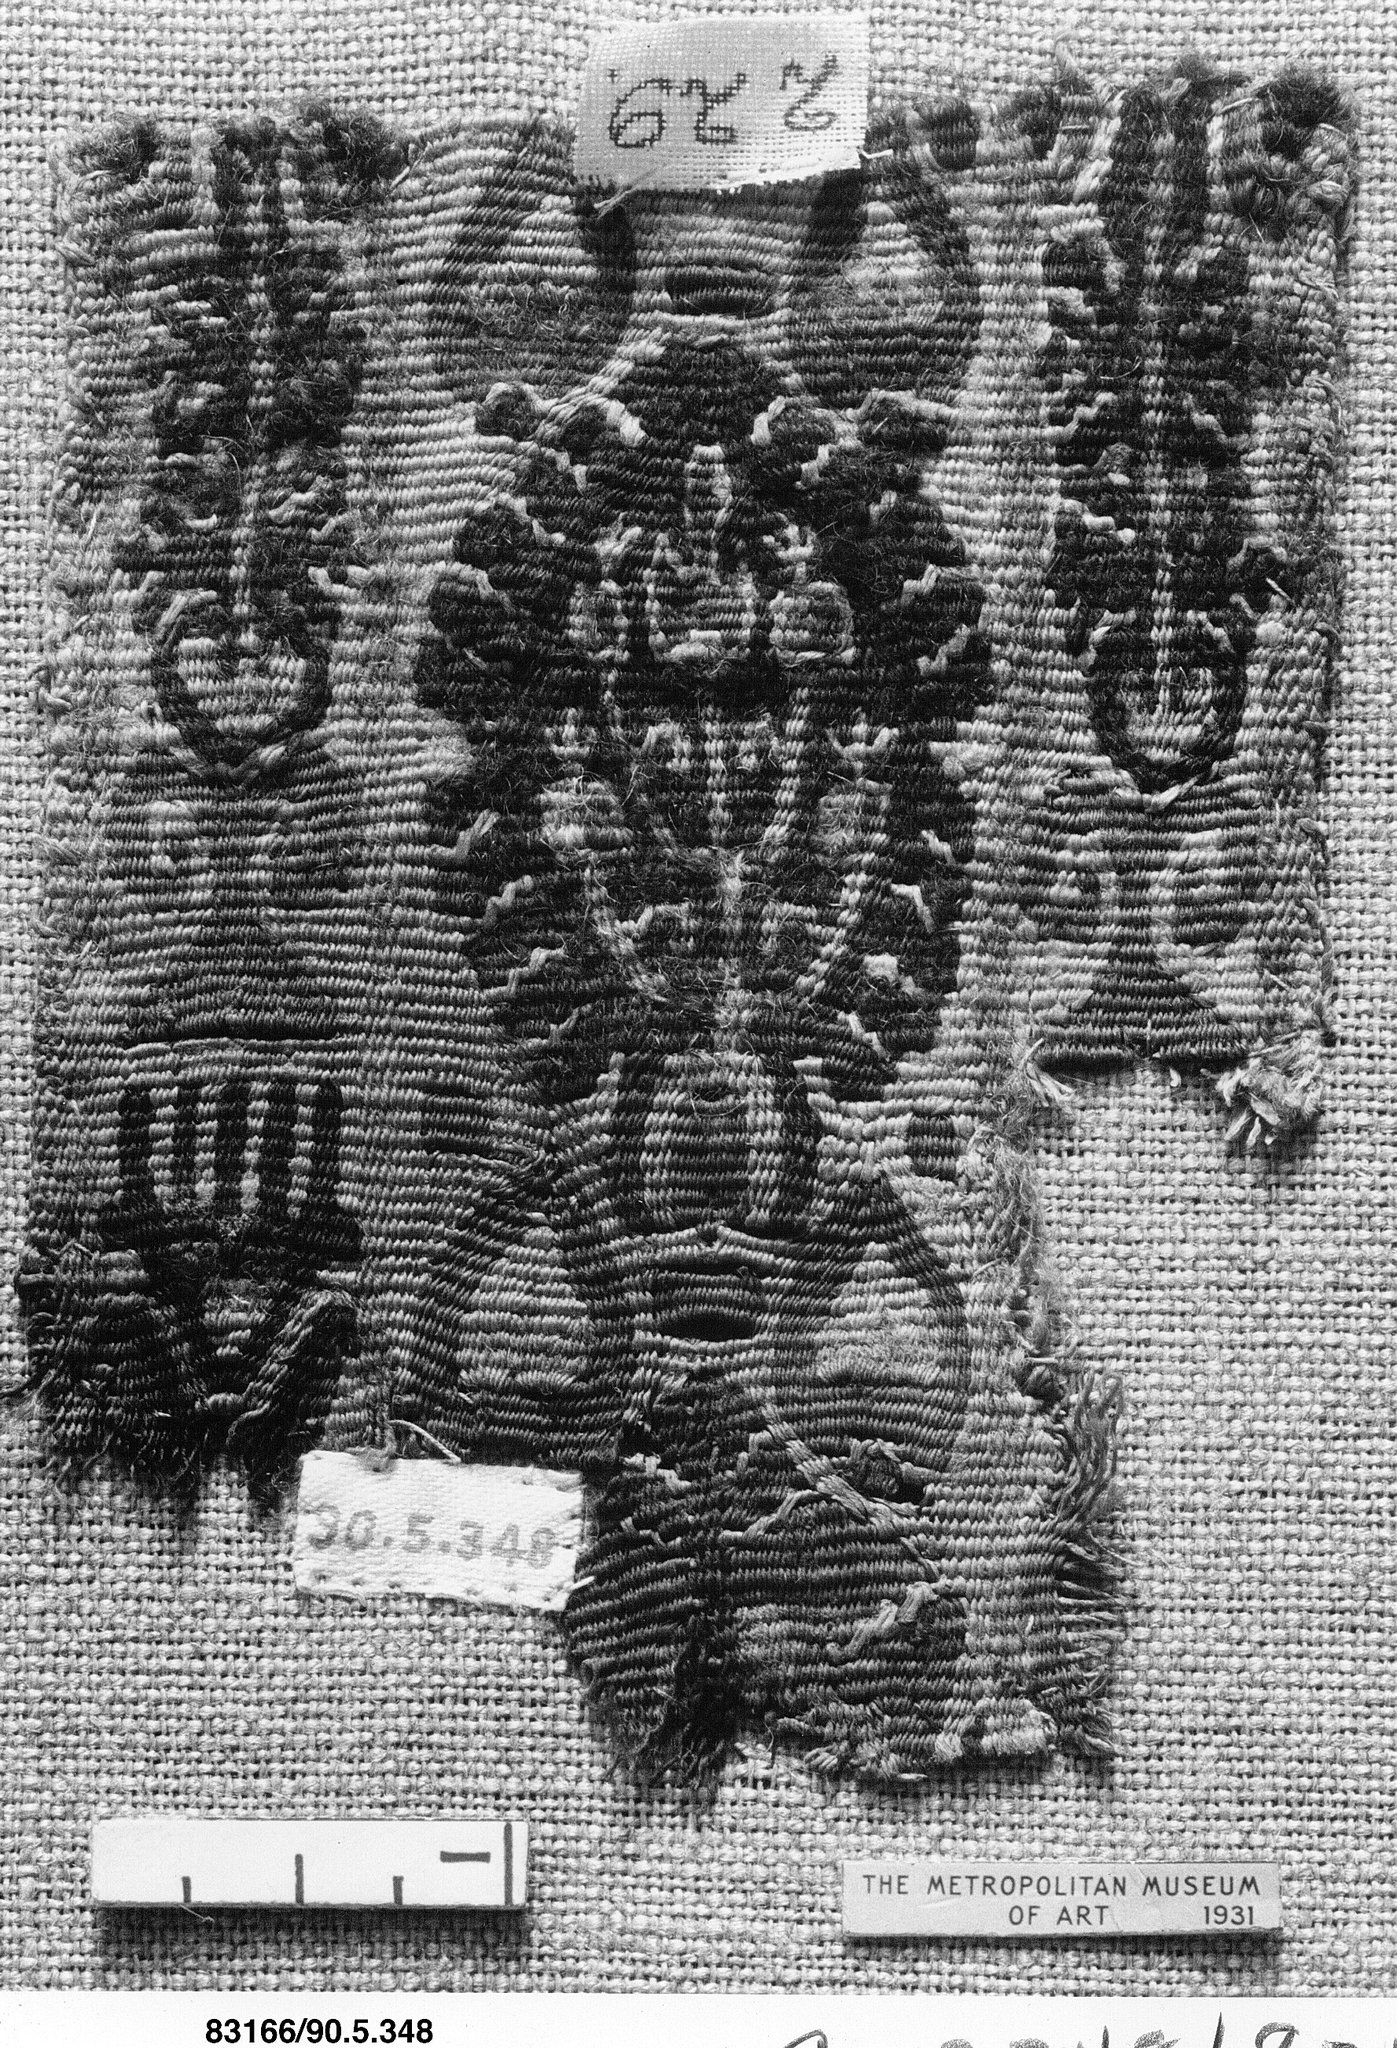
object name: textile fragment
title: Fragment of a Shoulder Band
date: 401-600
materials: linen, wool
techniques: weave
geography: egypt